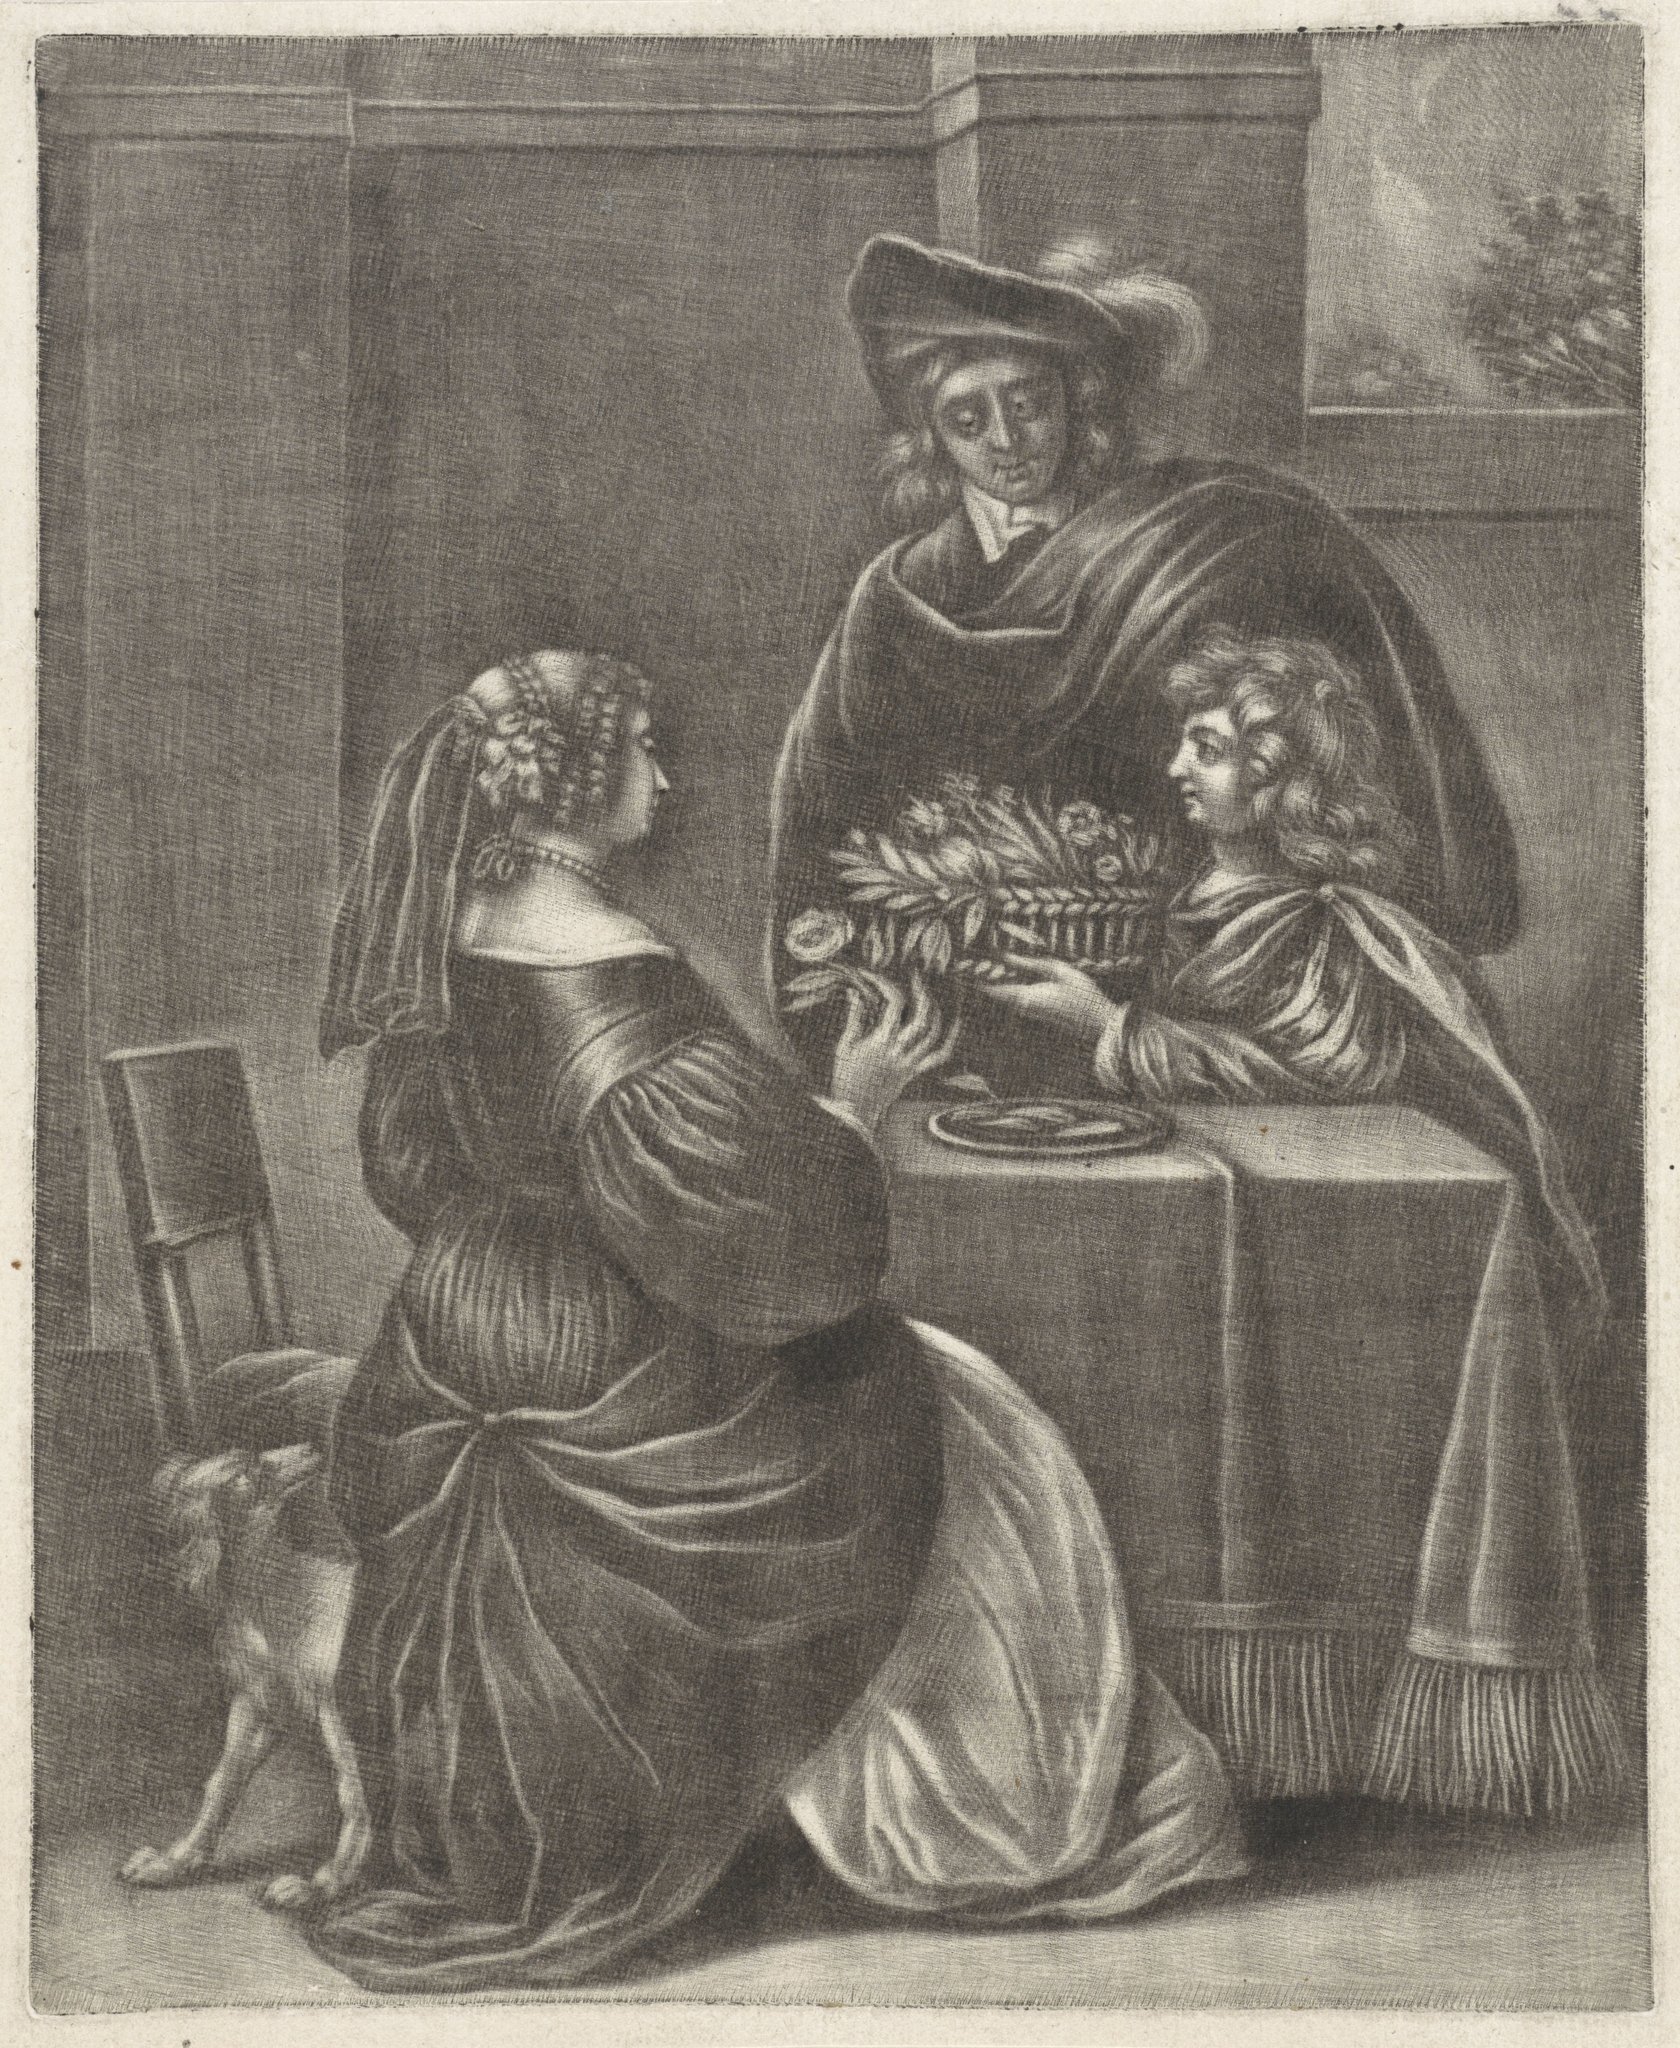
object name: print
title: Jongen die een mand bloemen aanbiedt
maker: jan van somer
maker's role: draughtsman, print maker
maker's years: 1645-1699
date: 1655-1700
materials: paper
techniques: mezzotint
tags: flowers, dog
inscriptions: collector's mark: Lugt 2228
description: In een interieur biedt een jongen een mand met bloemen aan, aan een vrouw. Zij zit aan tafel en pakt een van de bloemen uit de mand. Naast de jongen staat een man met een gevederde hoed.